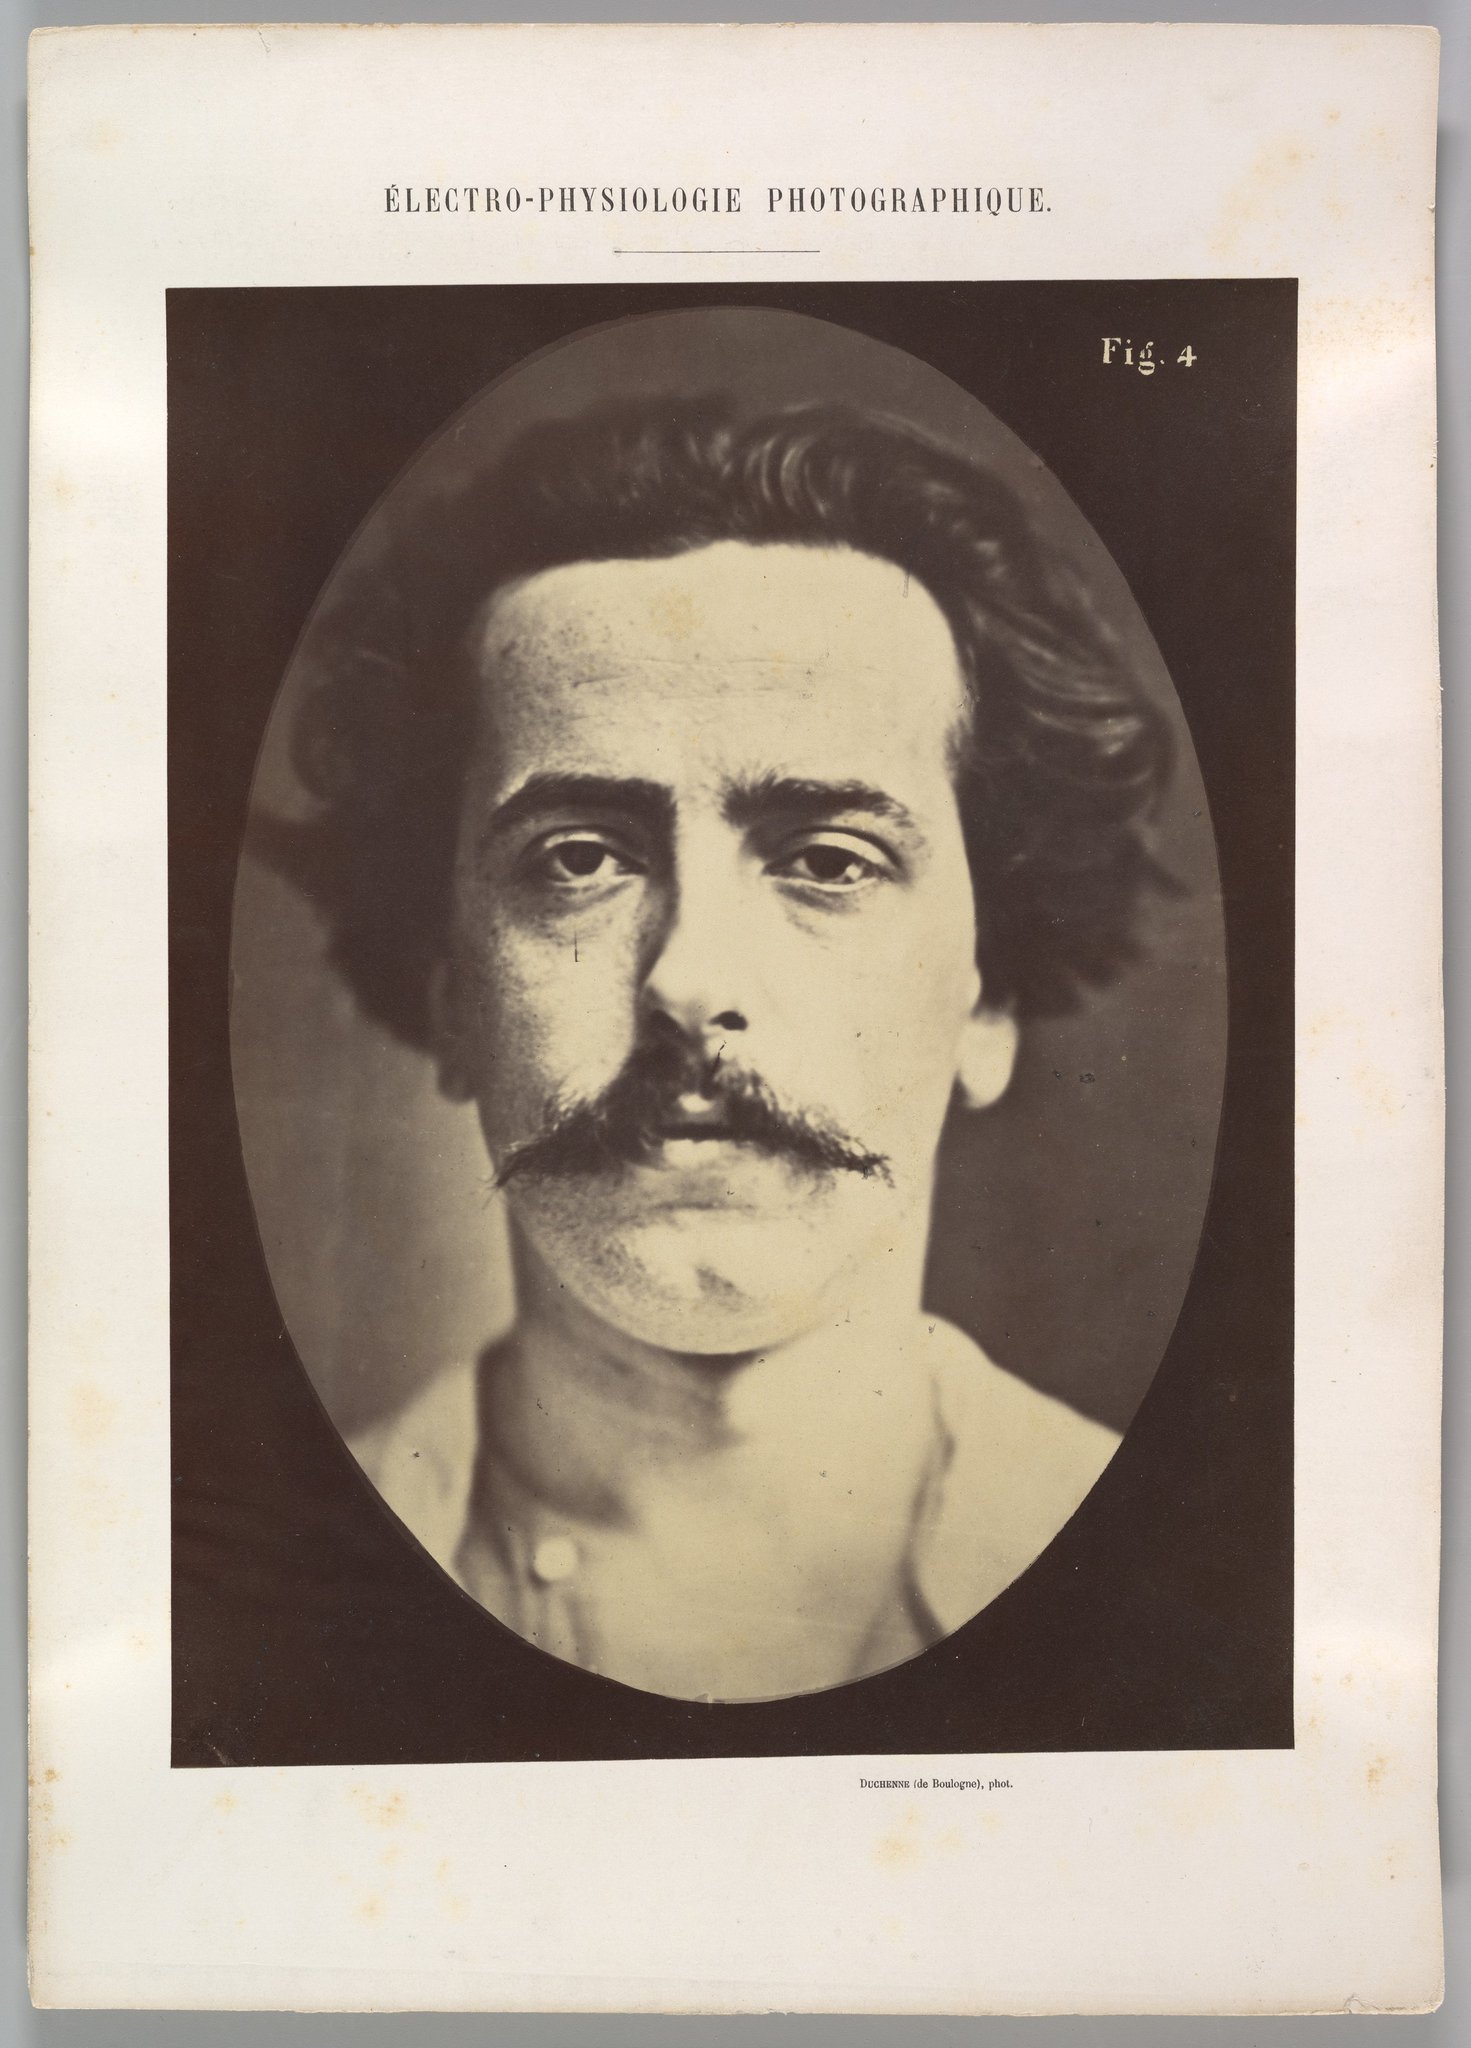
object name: photograph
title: Figure 4: The face in repose of a young man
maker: guillaume-benjamin-amand duchenne de boulogne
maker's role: artist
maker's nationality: french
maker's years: 1806-1875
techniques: albumen silver print, glass negative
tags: science,men,portraits